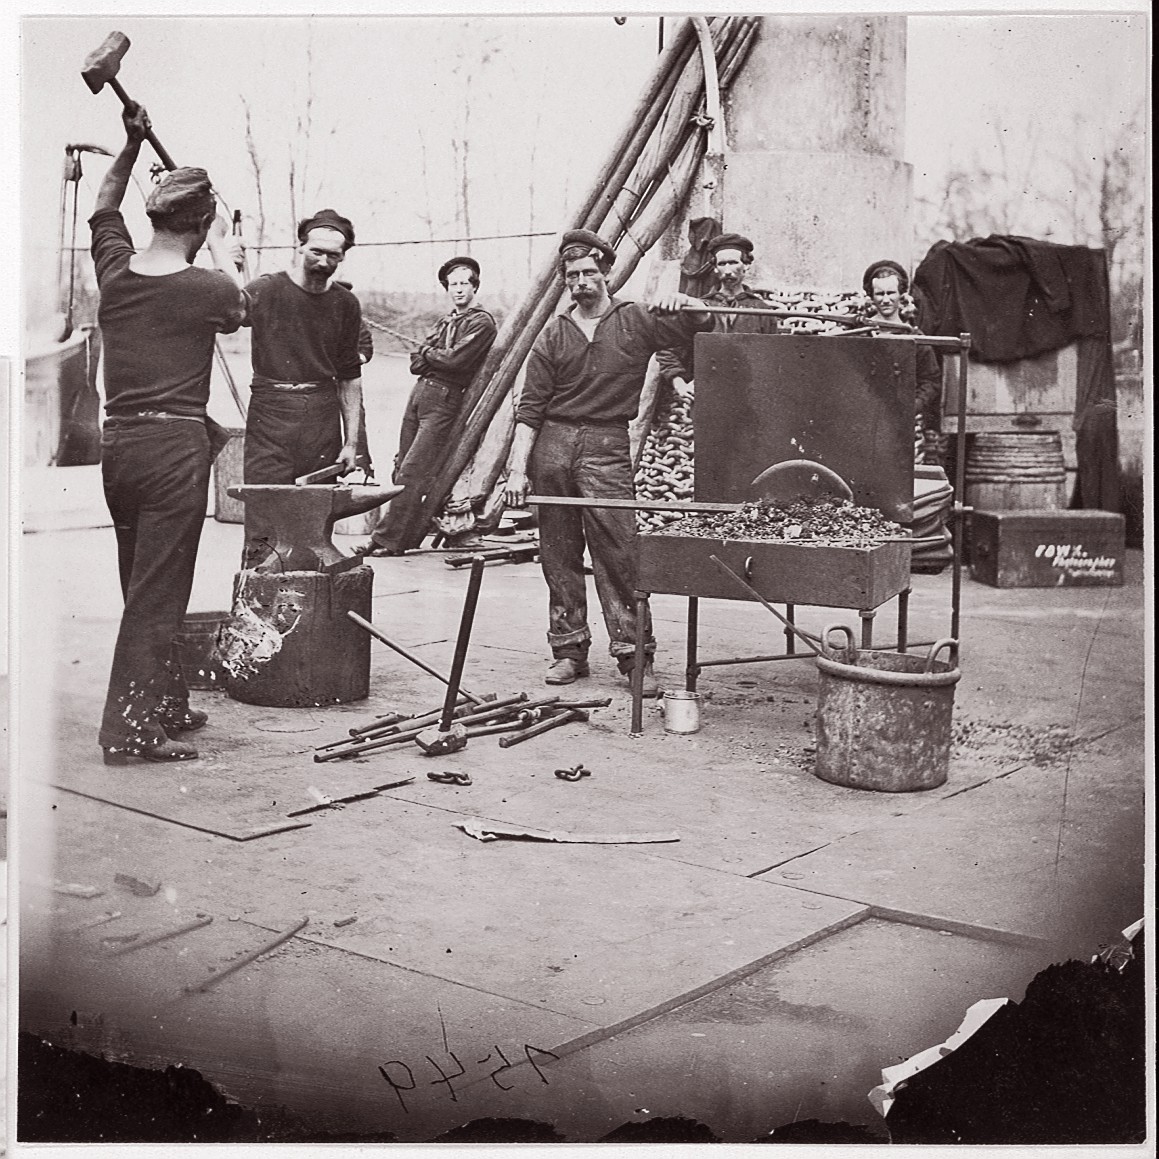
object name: photograph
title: Officers of U.S.S. Hunchback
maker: Anonymous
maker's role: artist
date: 1861-1865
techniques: albumen silver print, glass negative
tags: american civil war,men